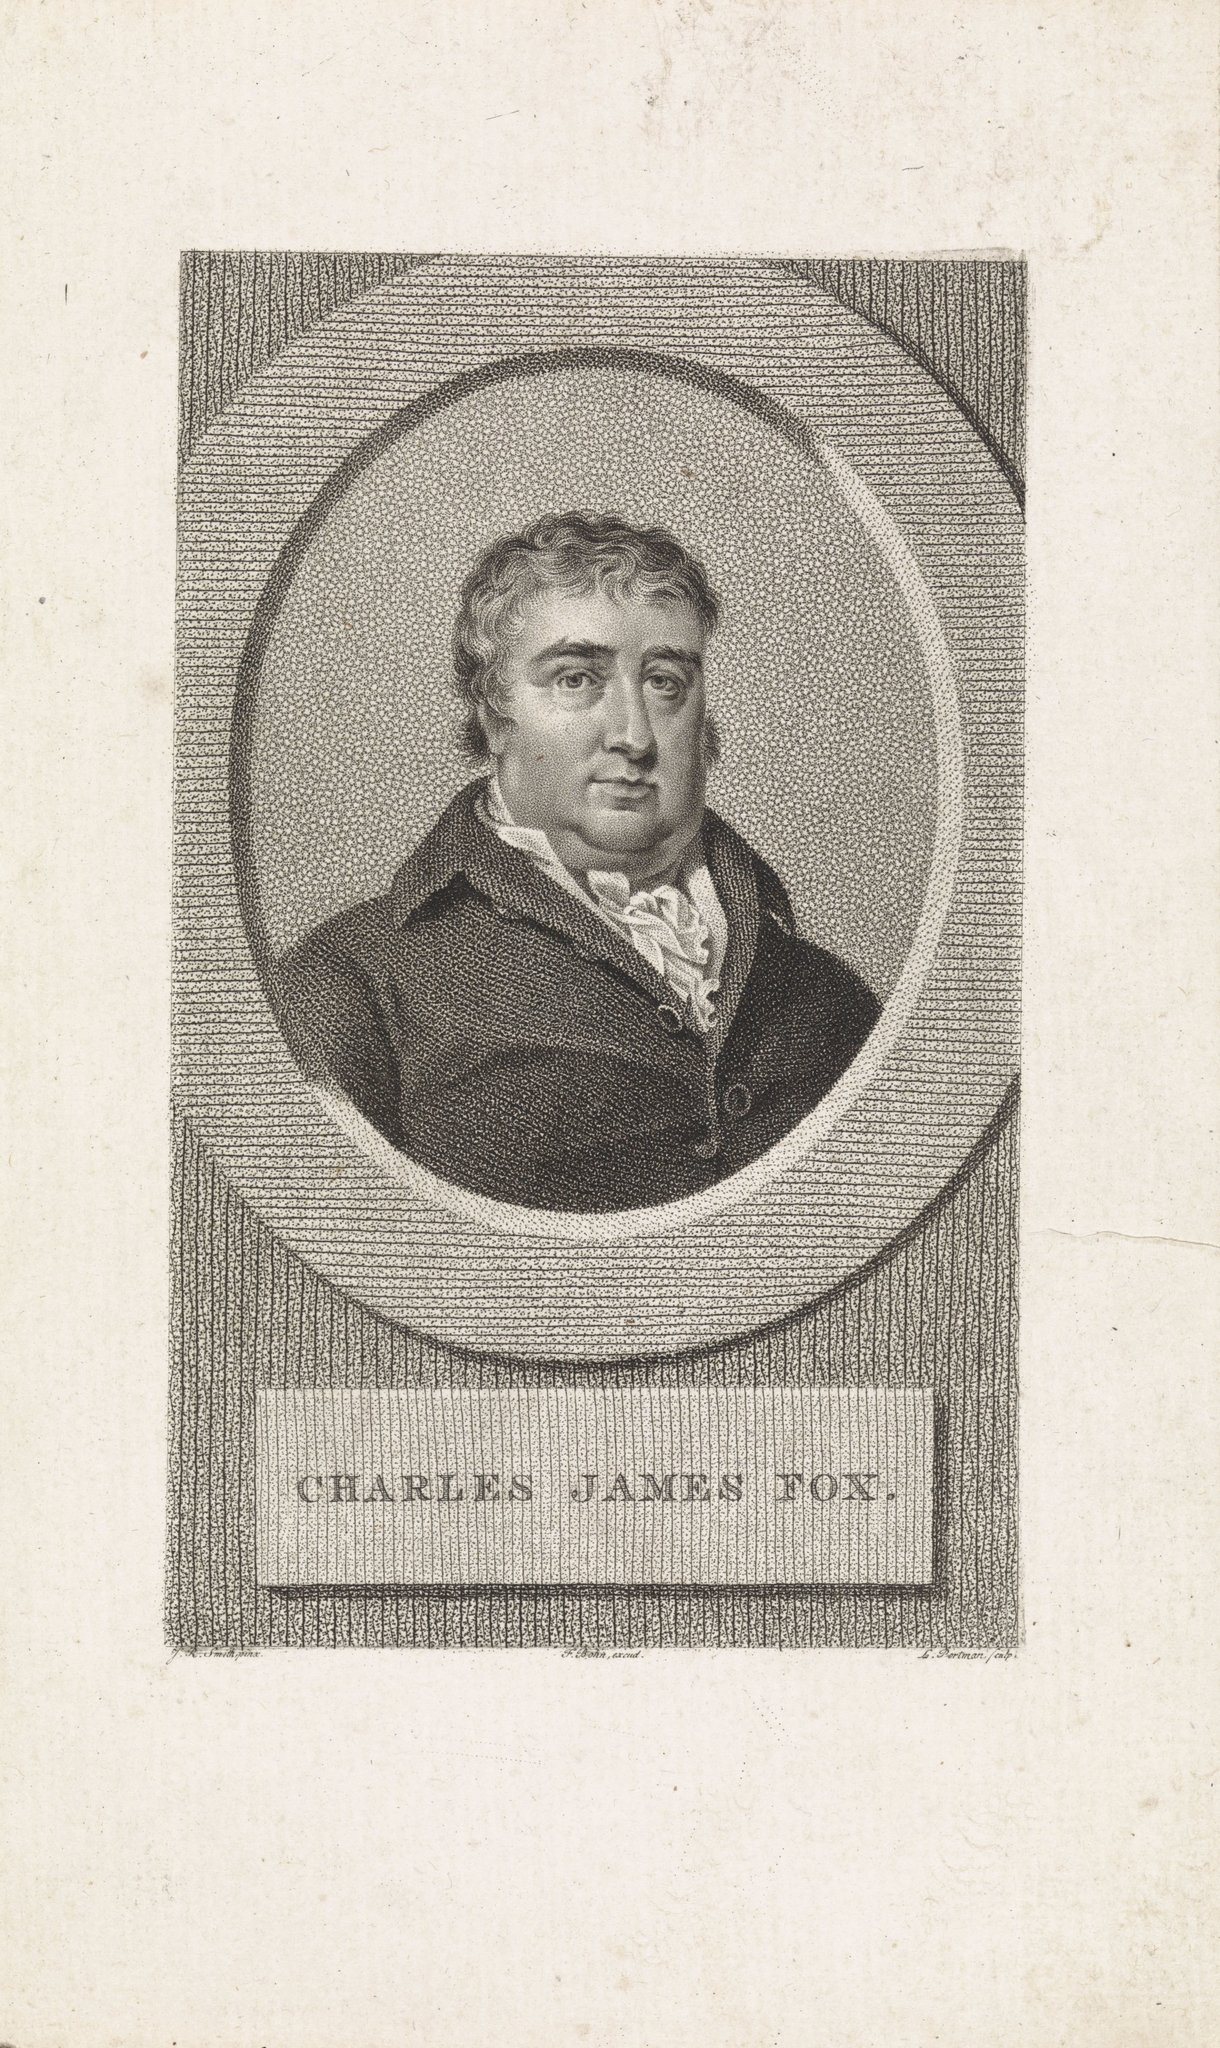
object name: print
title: Portret van de Engelse staatsman Charles James Fox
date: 1787-1828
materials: paper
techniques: stippled etching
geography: amsterdam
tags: london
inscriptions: collector's mark: Lugt 2228